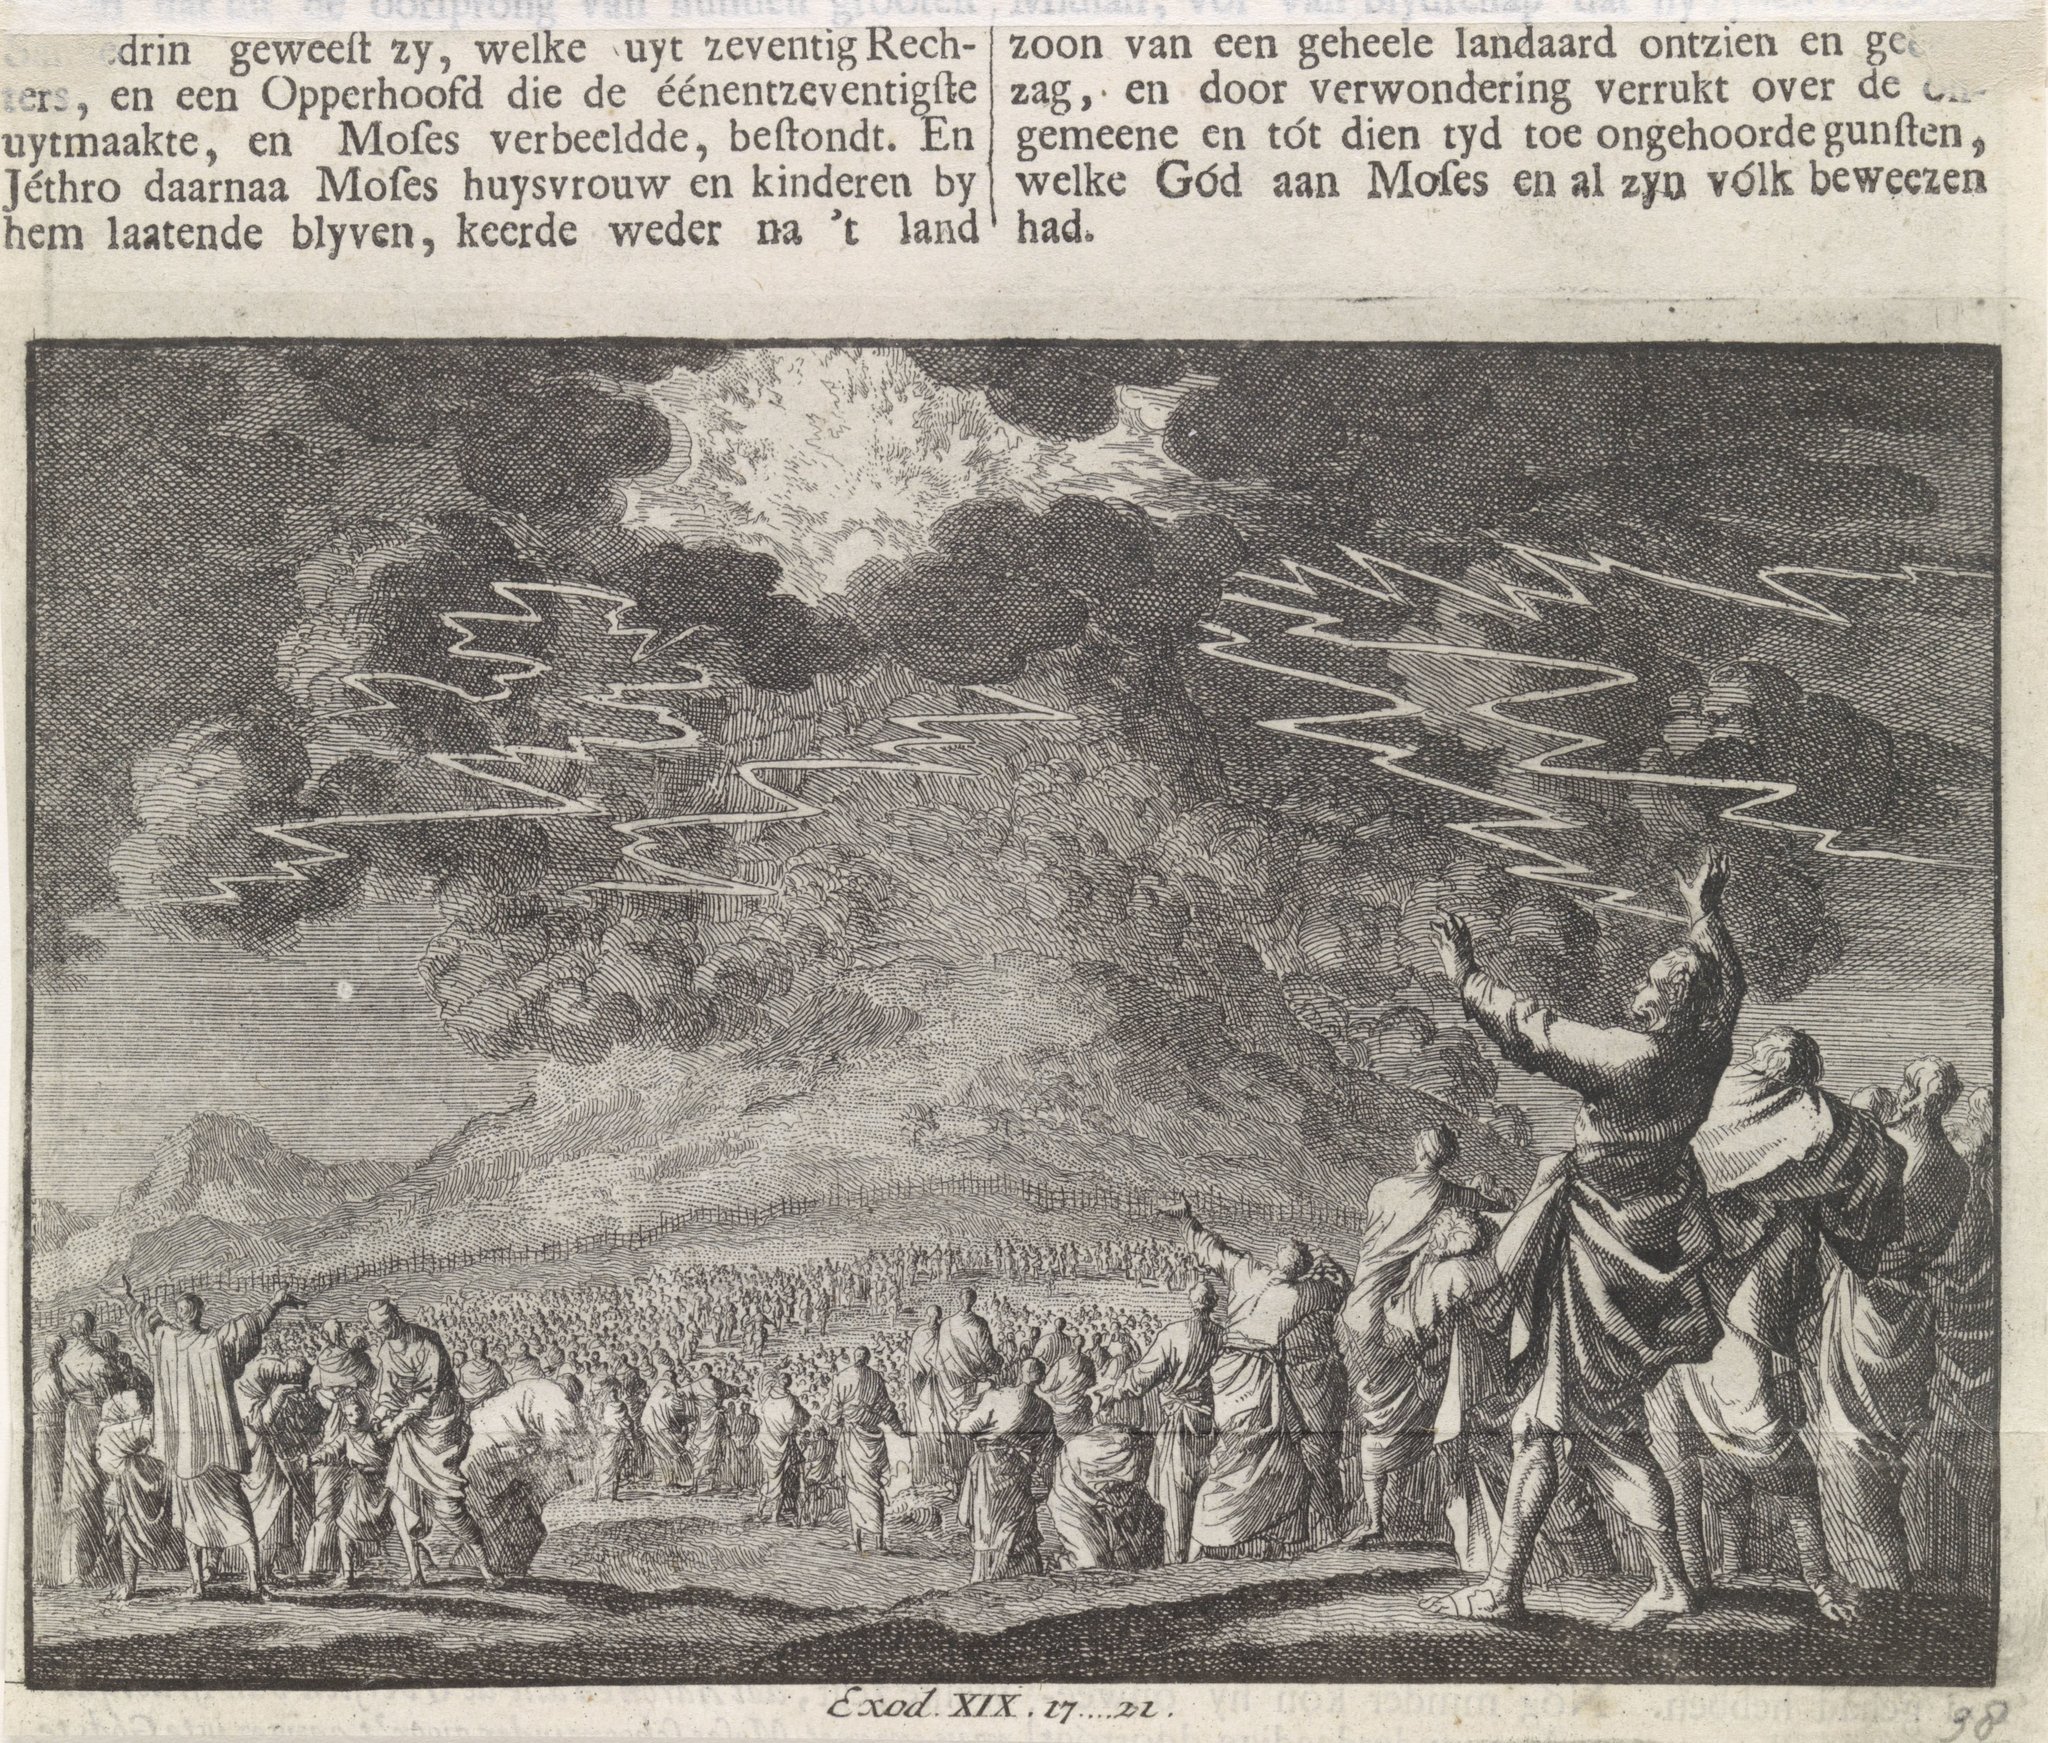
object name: print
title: Mozes op de berg Sinaï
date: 1703-1762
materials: paper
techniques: etching, letterpress printing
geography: amsterdam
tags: mount sinai is covered by a thick cloud, thunder and lightning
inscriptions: collector's mark: Lugt 2228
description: De prent komt een eerste keer voor als boekillustratie voor David Martin. Historie des Ouden en Nieuwen Testaments. Amsterdam, Pieter Mortier, 1703. Deel I. De boekillustraties voor de Mortierbijbel hebben verschillende staten en kopieën, waarbij de chronologische volgorde moeilijk te achterhalen valt. Als boekillustraties werden ze bovendien herhaaldelijk opnieuw gebruikt voor andere boekwerken.